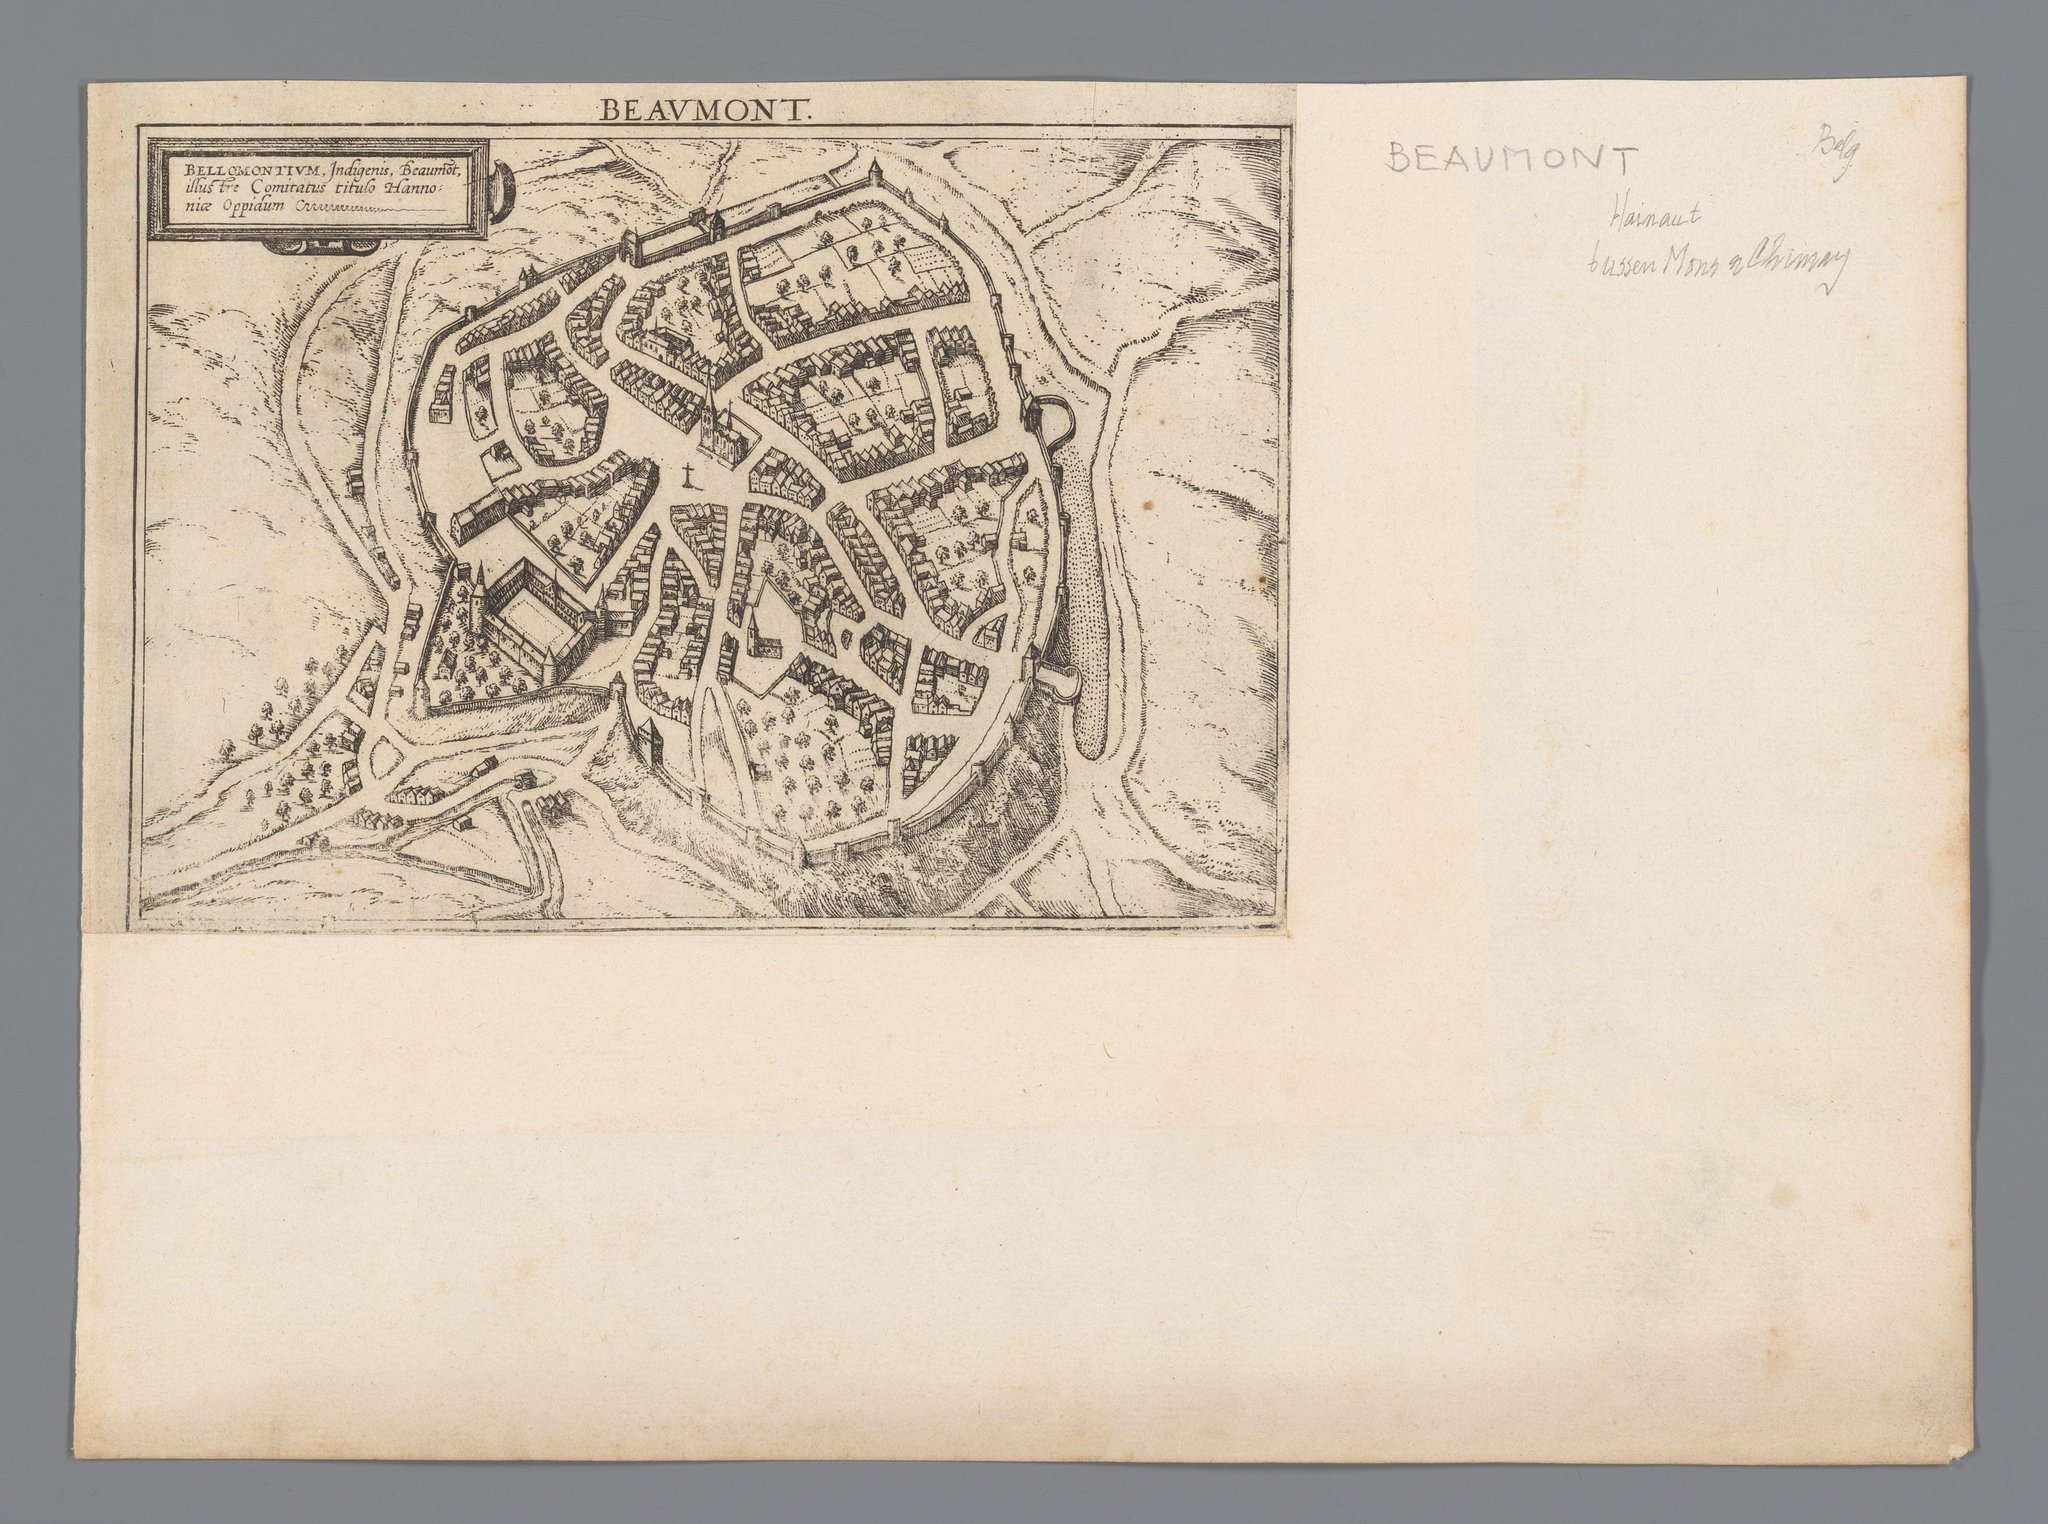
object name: print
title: Plattegrond van Beaumont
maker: Anonymous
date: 1650-1675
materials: paper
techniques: etching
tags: maps of cities